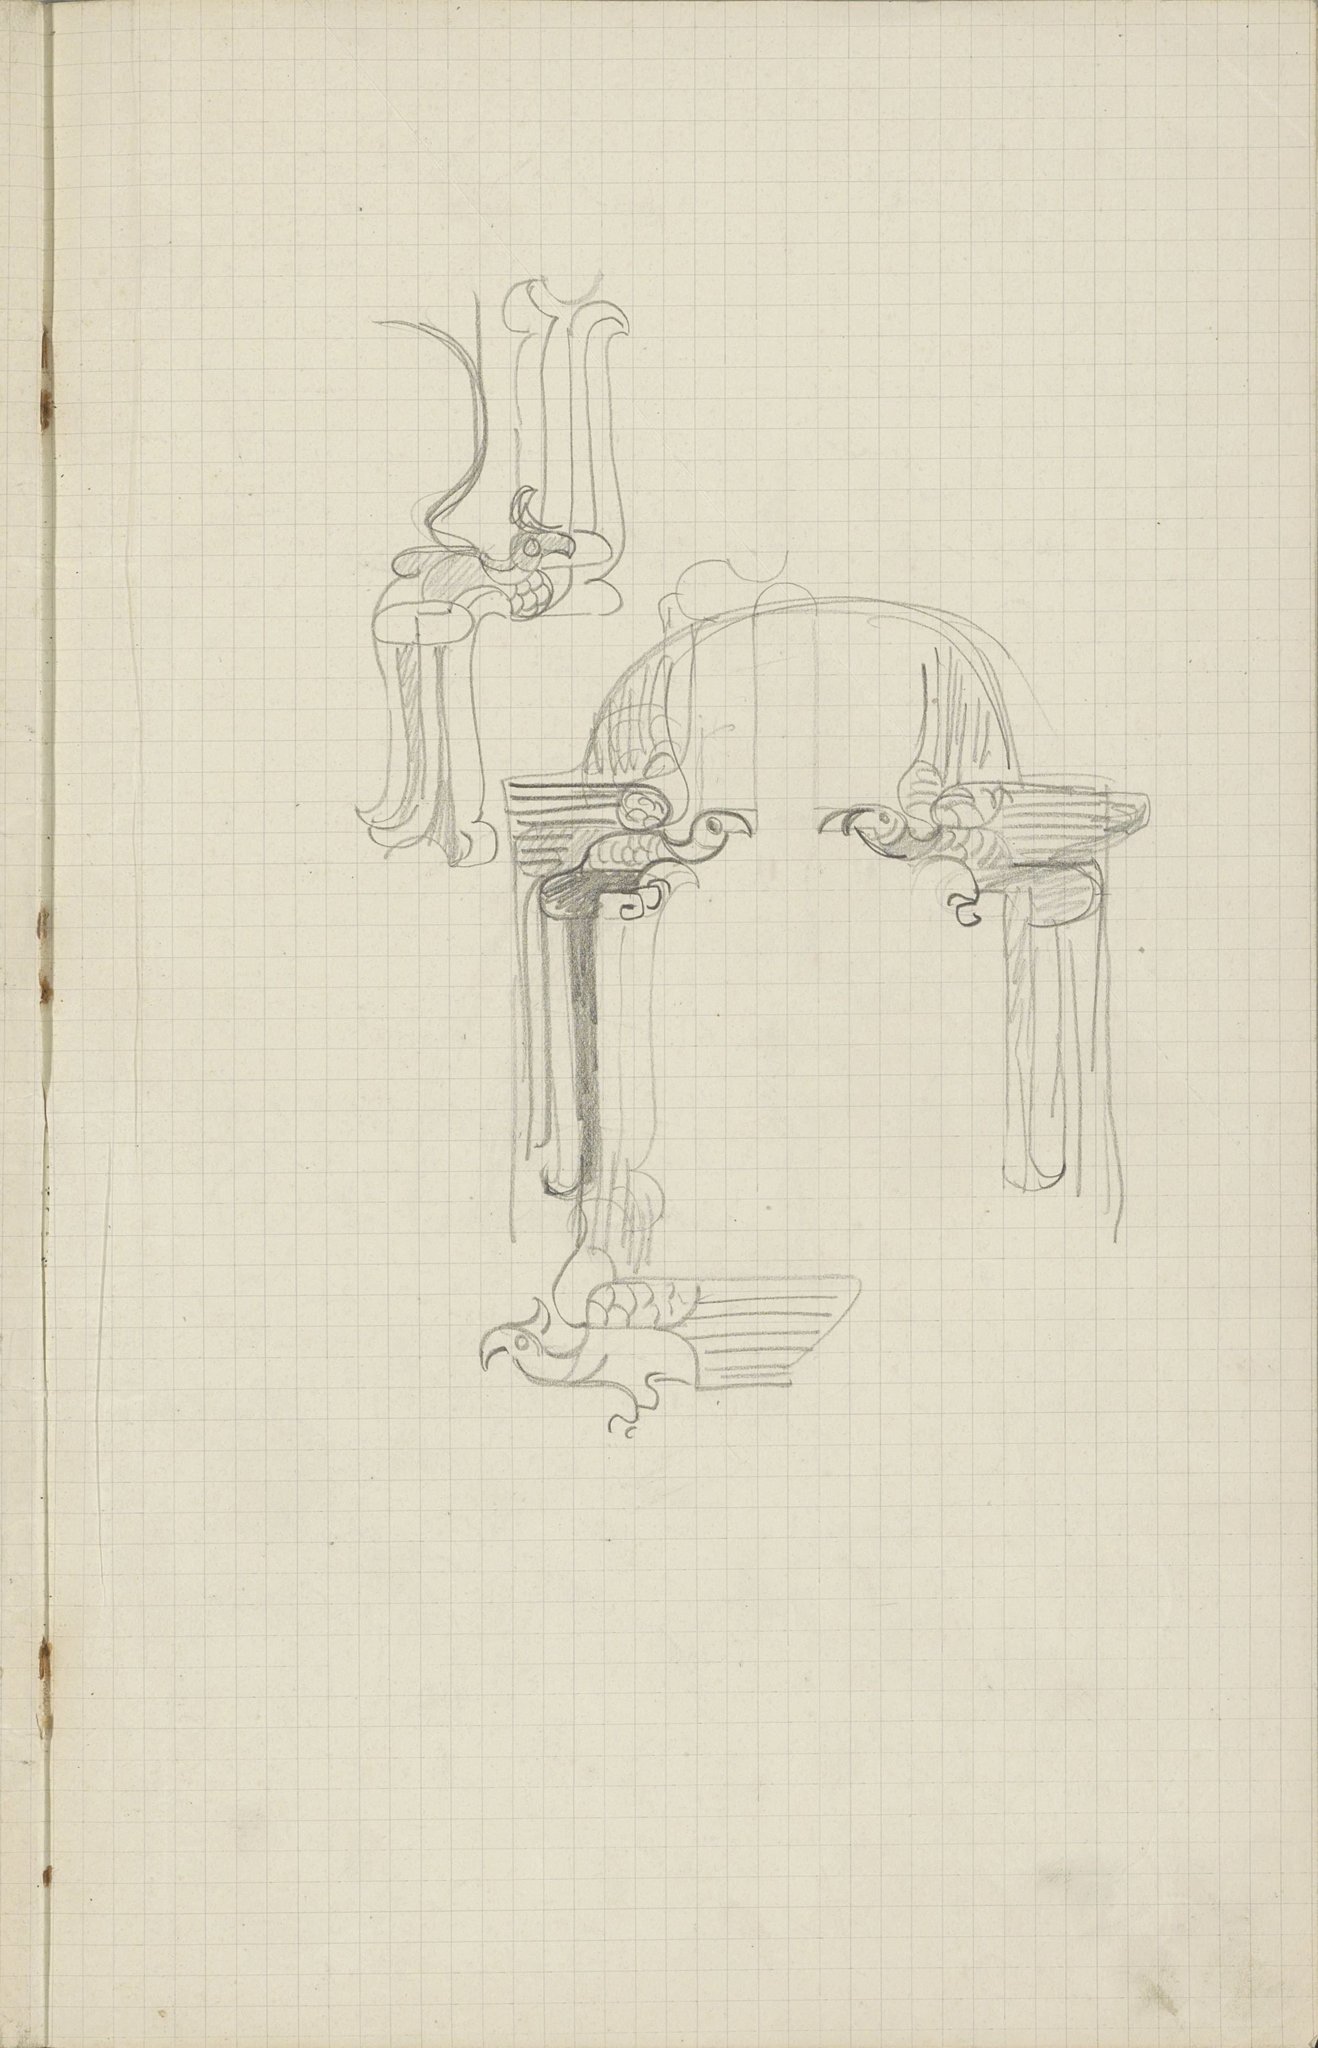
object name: sketchbook leaf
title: Ornamenten met papegaaien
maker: carel adolph lion cachet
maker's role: draughtsman, print maker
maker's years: 1864-1945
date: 1874-1945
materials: pencil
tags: ornament derived from animal forms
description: Blad 6 recto uit een schetsboek met 9 bladen.